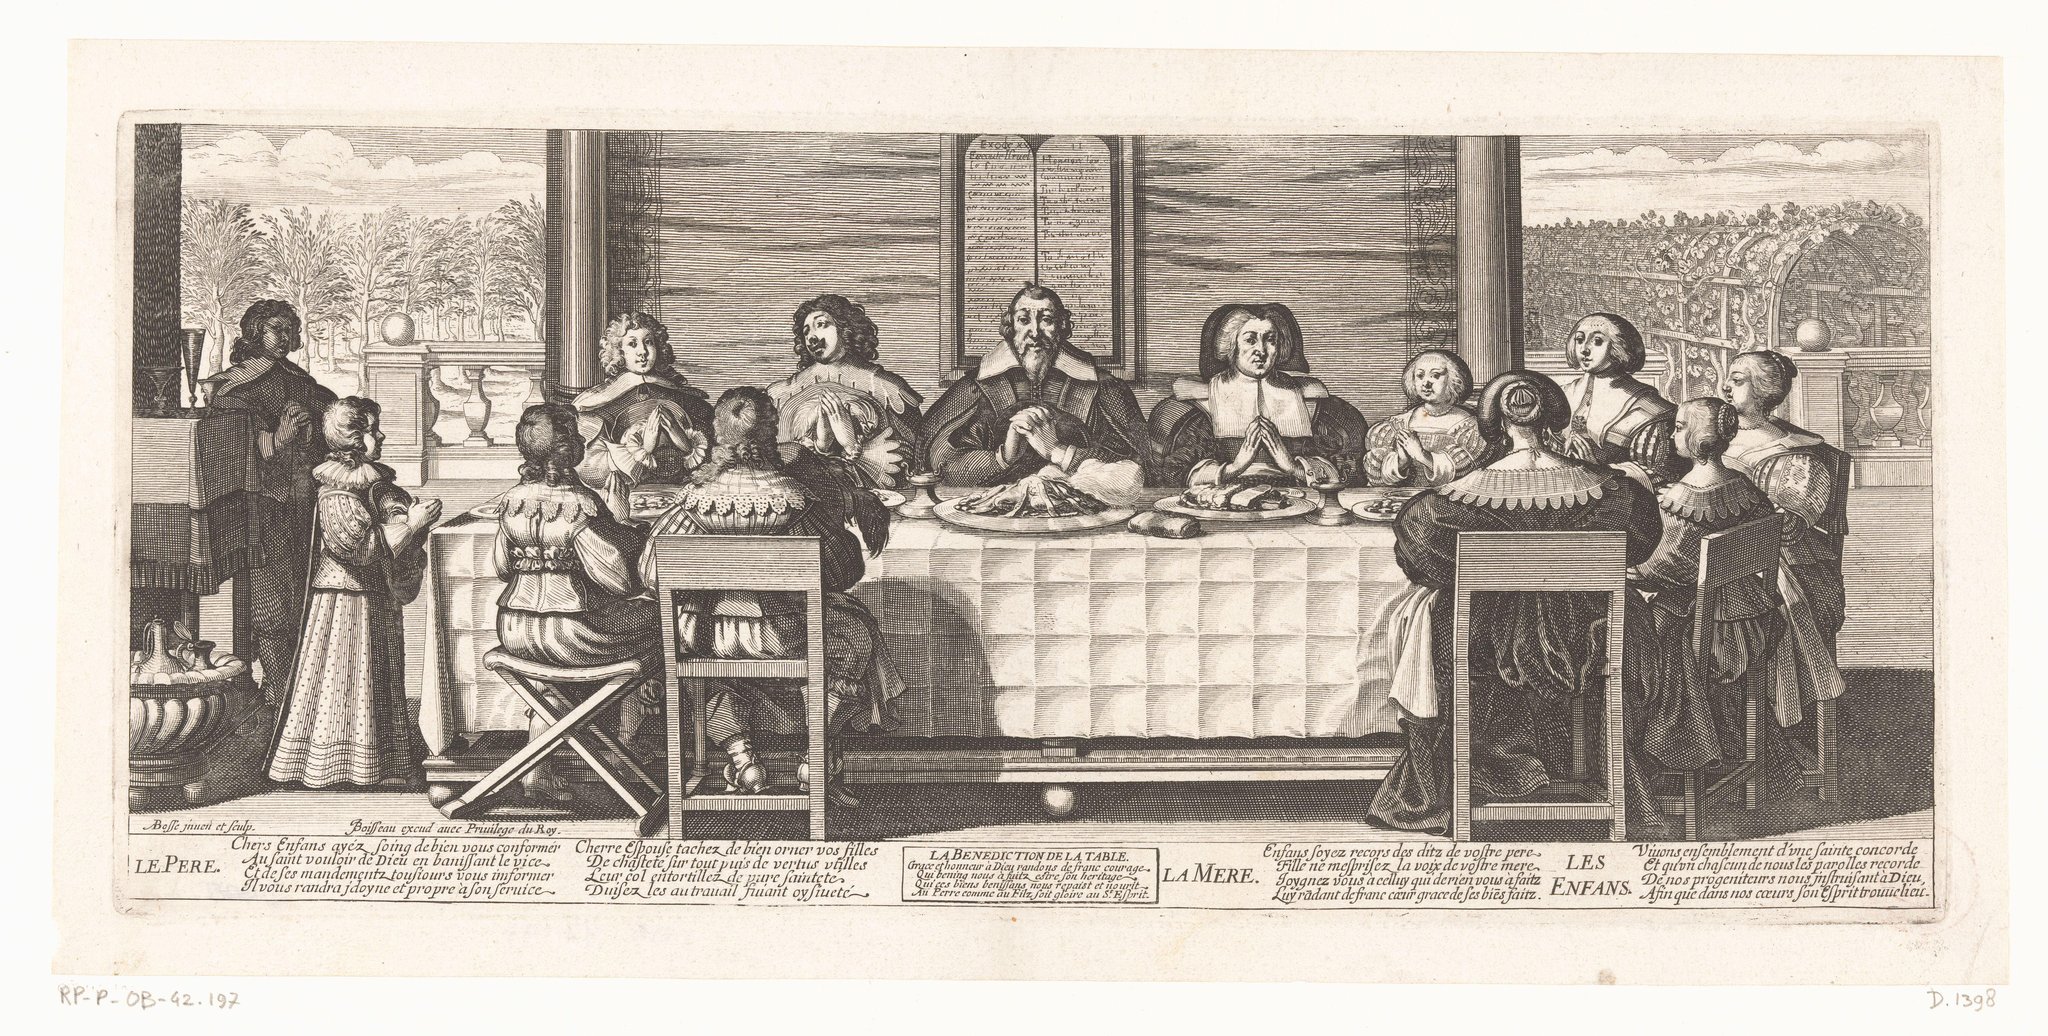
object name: print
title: La Benediction de la Table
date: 1635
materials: paper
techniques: etching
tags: clothes, costume (+ children's clothes), clothes, costume (+ women's clothes), clothes, costume (+ men's clothes), prayer at table, saying grace, the ten commandments represented together on stone tablets, table-cloth, (family) meal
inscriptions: collector's mark: Lugt 240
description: Modieus geklede familie, zittend aan een lange tafel, de handen gevouwen voor het gebed voor de maaltijd. De vader en moeder zitten in het midden, gezicht naar de beschouwer gekeerd, voor een afbeelding van de Tafelen der Wet aan de muur. Enkele figuren op de rug gezien. Links een staand kind en een staande jongeman naast een tafel en bassin met wijnkruiken. De tafel is gedekt met een in ruiten gesteven tafellaken, waarop enkele grote schotels. Door twee openingen links en rechts een gezicht op een tuin. Onder de voorstelling teksten in het Frans waarin de vader zich tot zijn kinderen en echtgenote richt en de moeder haar kinderen tot gehoorzaamheid aan de vader maant. In de tekst van de kinderen wordt tot saamhorigheid gemaand.